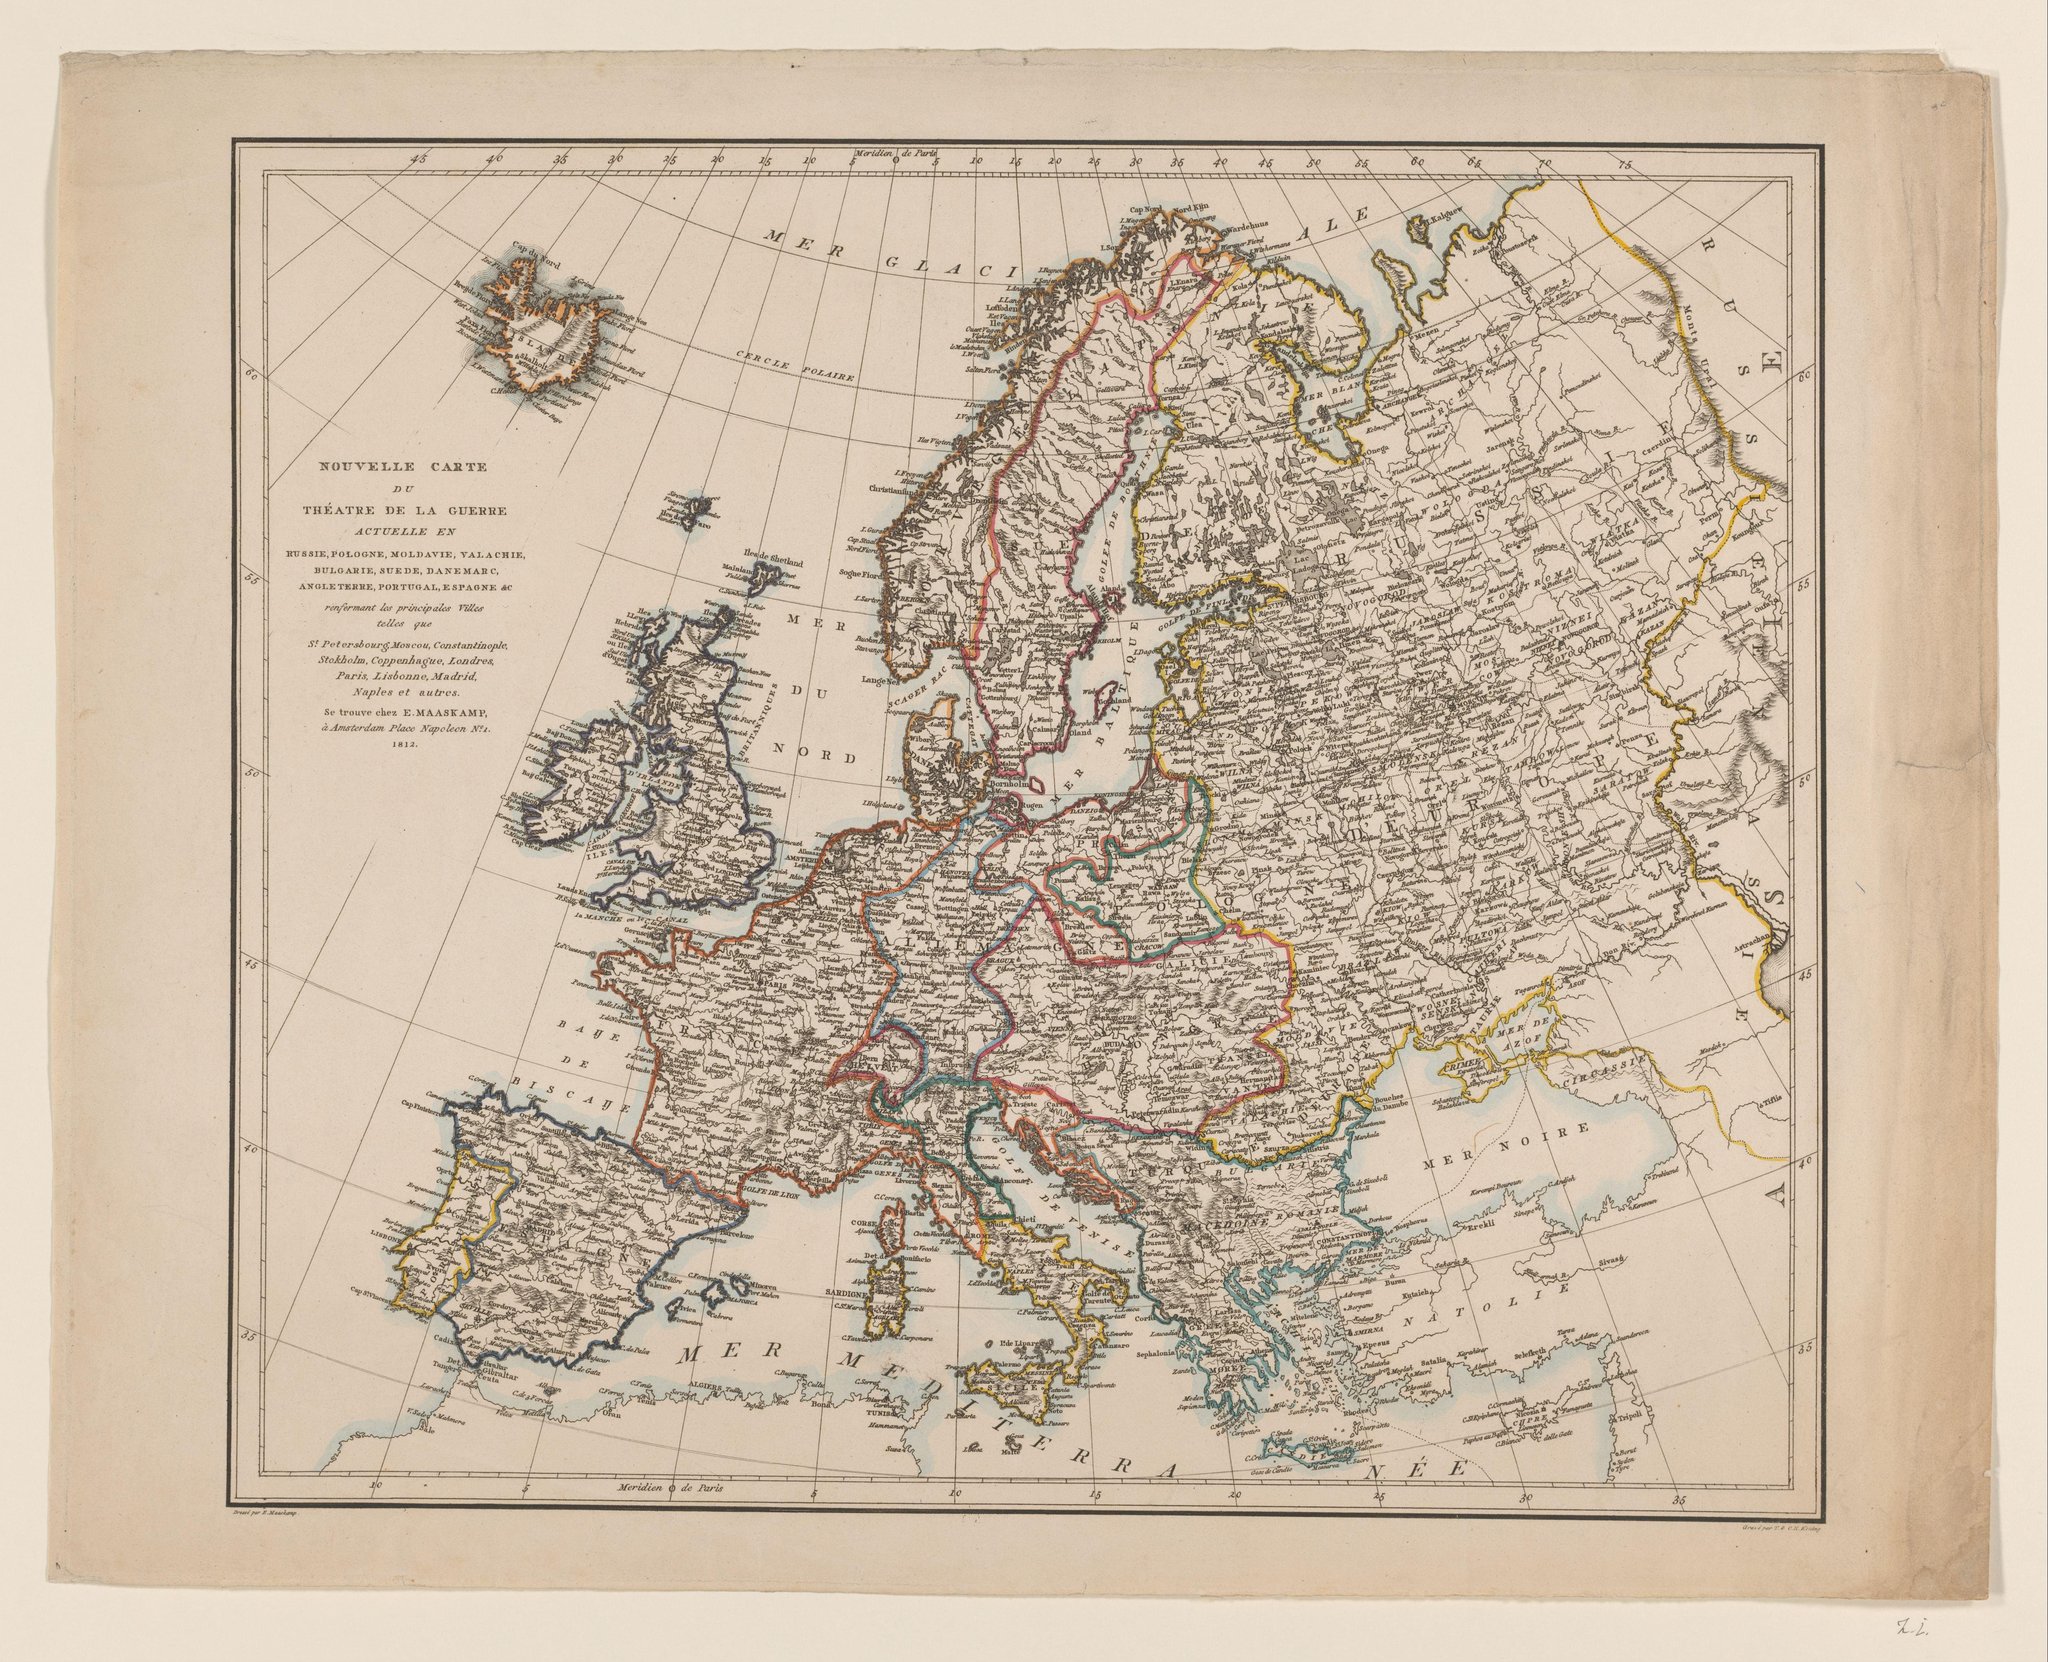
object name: print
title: Kaart van Europa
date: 1812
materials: paper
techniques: engraving, hand coloring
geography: amsterdam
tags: maps, atlases, europe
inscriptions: collector's mark: Lugt 2760